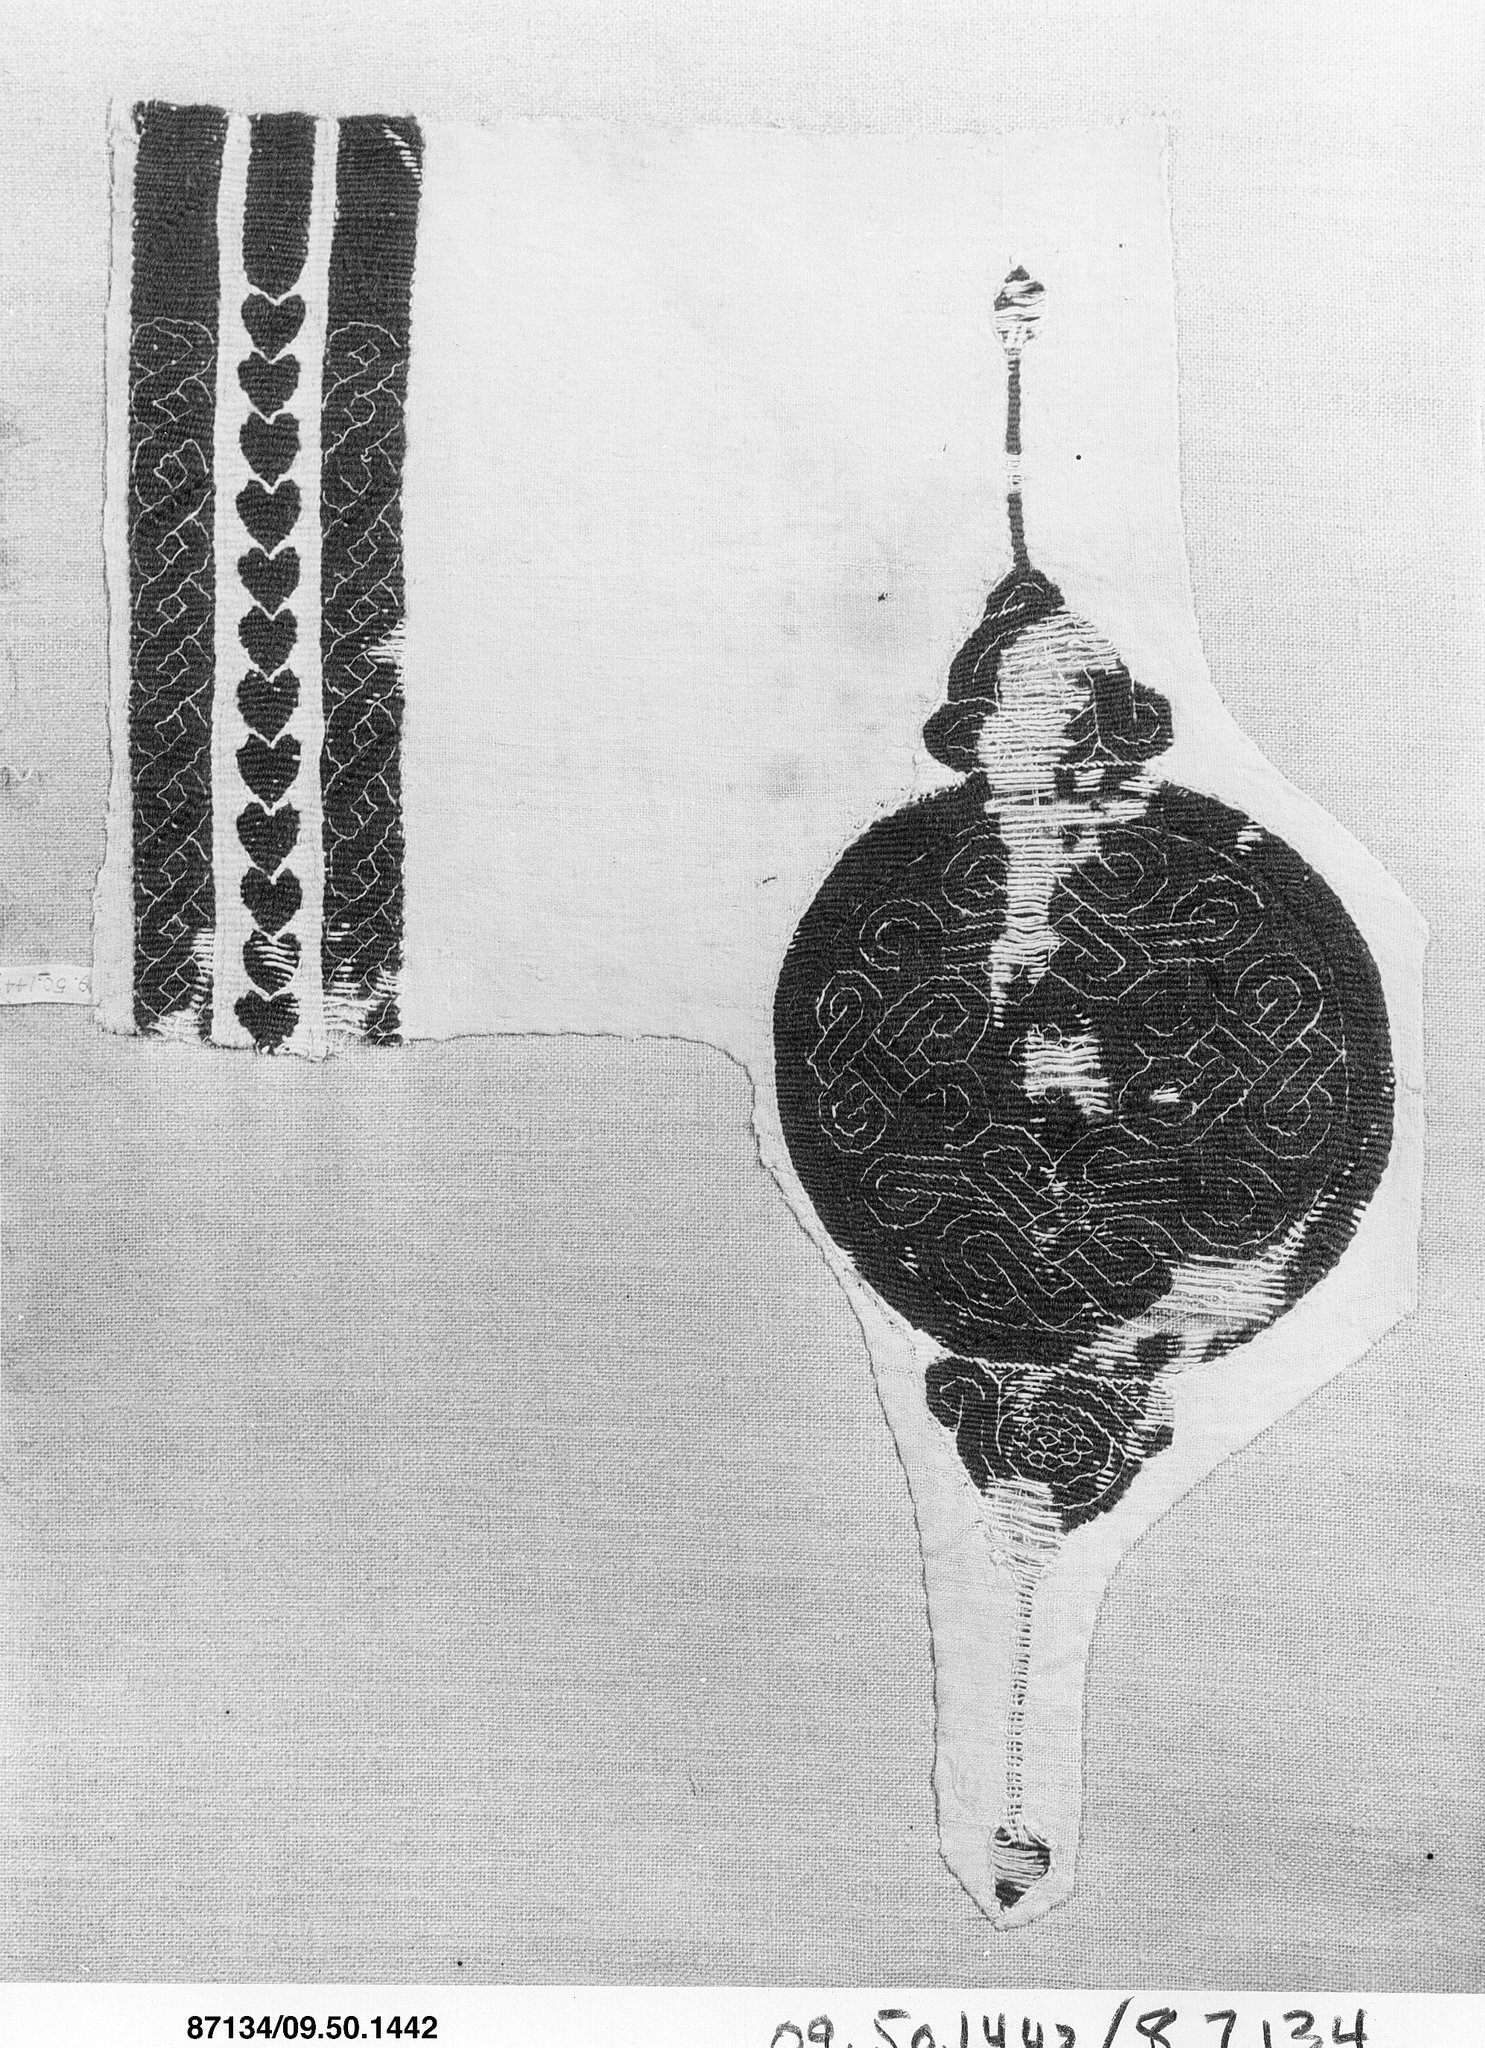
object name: textile fragment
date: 201-400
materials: linen, wool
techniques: weave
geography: egypt